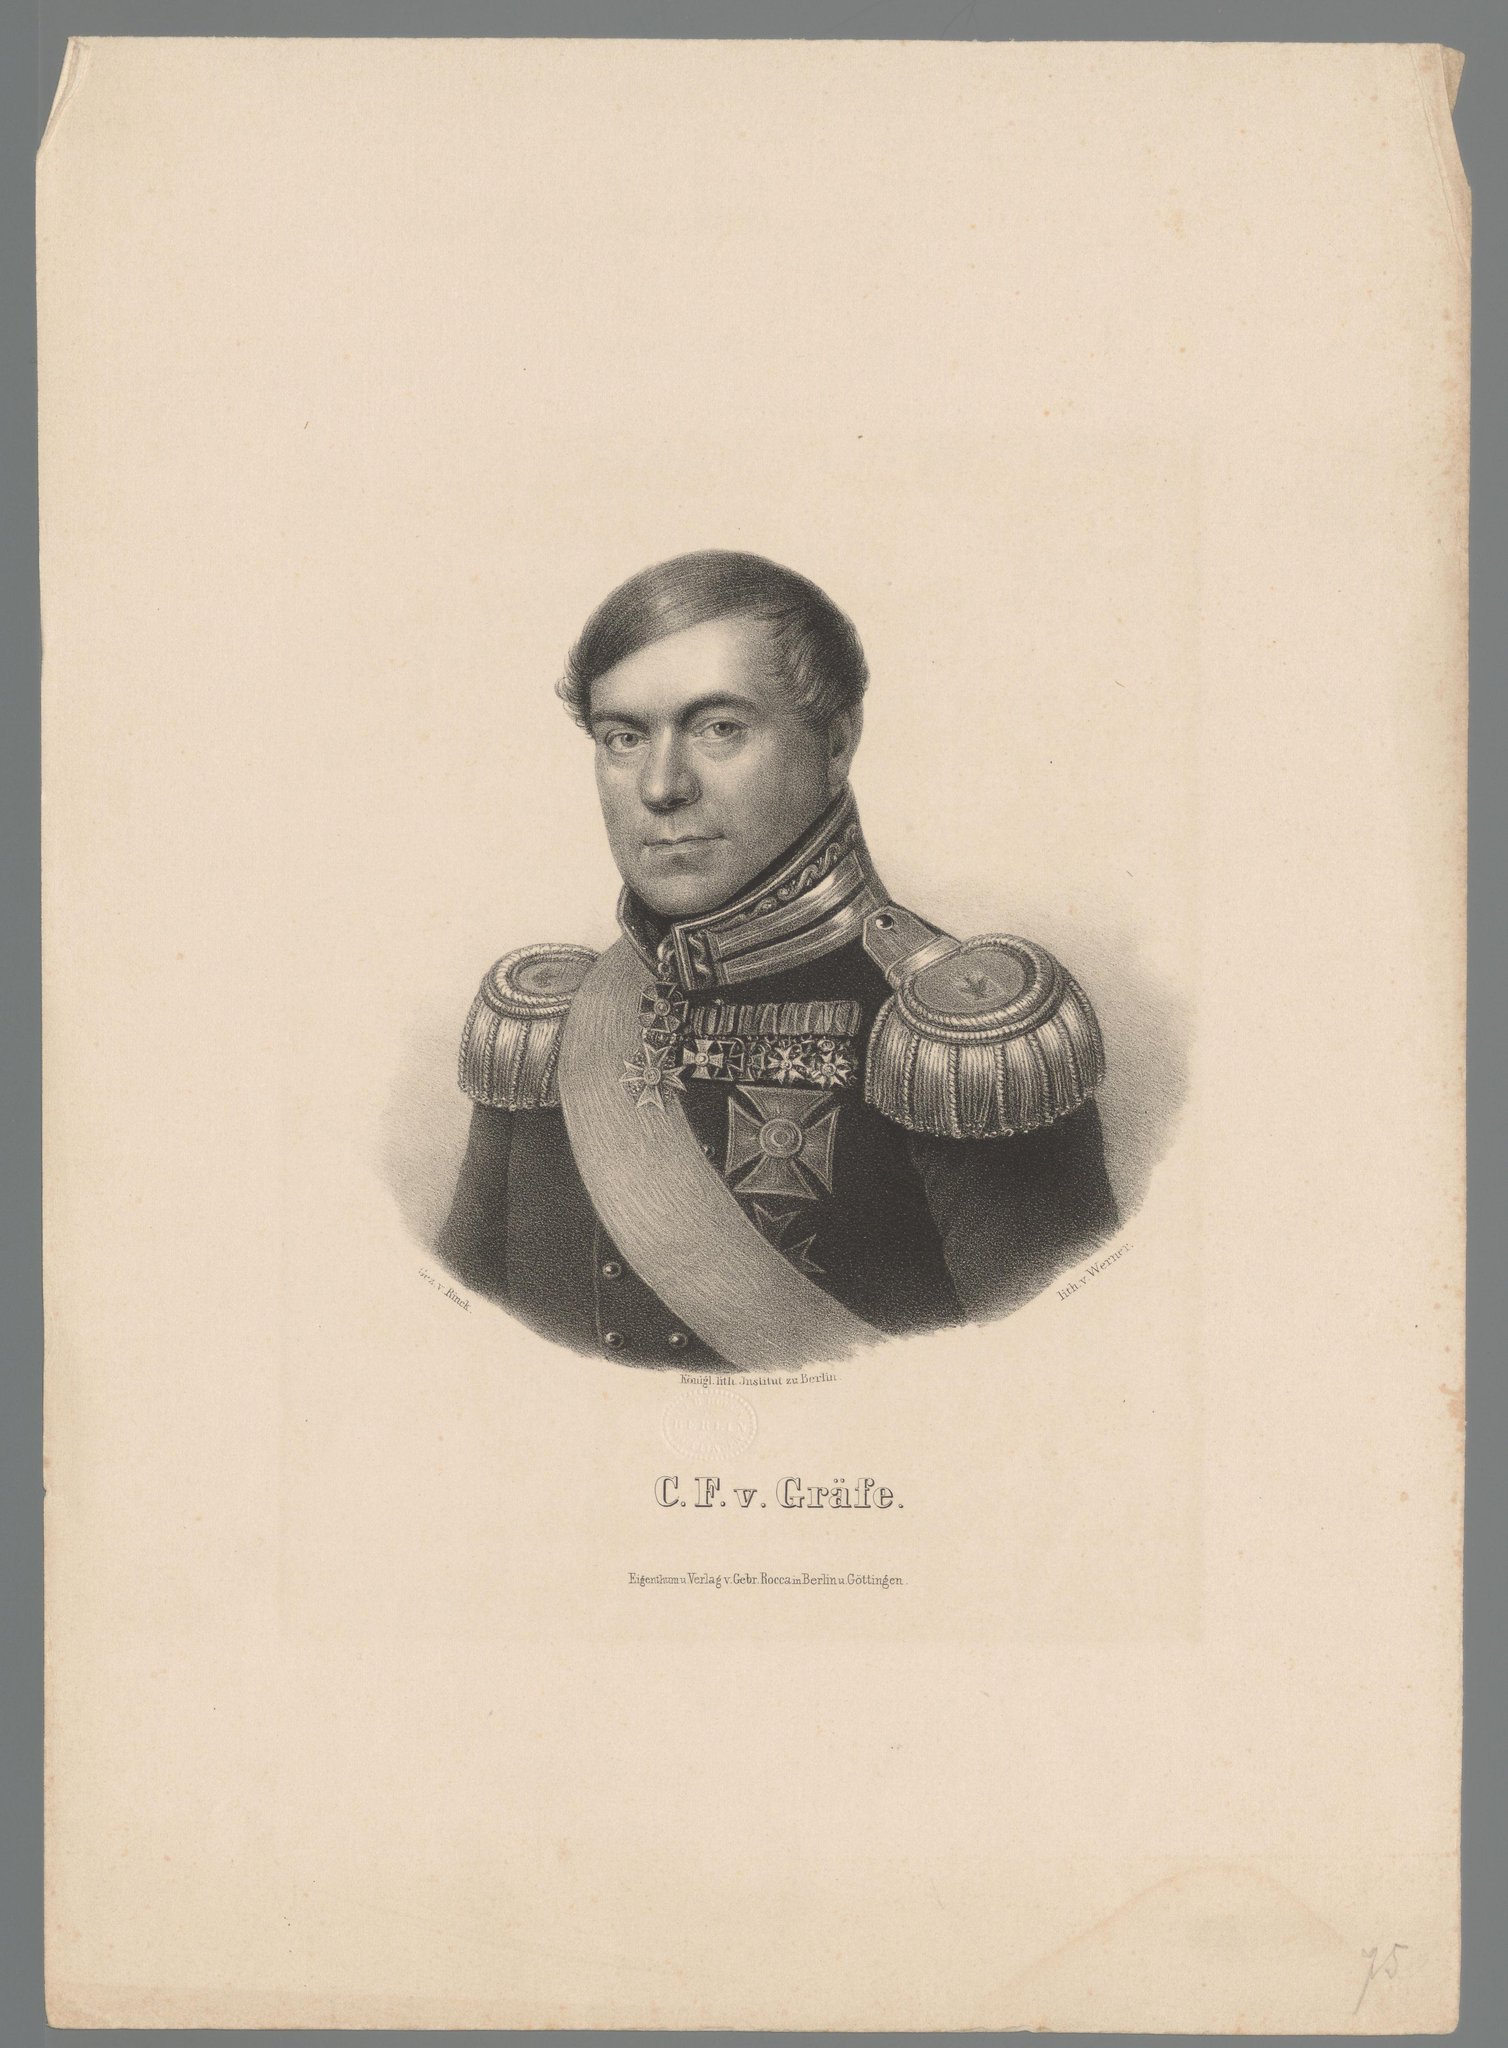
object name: print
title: Portret van Karl Ferdinand von Gräfe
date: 1830-1863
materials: paper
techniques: lithograph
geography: berlin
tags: karl ferdinand von gräfe, adult man, historical persons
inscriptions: collector's mark: Lugt 2228, check stamp: Lugt 5514